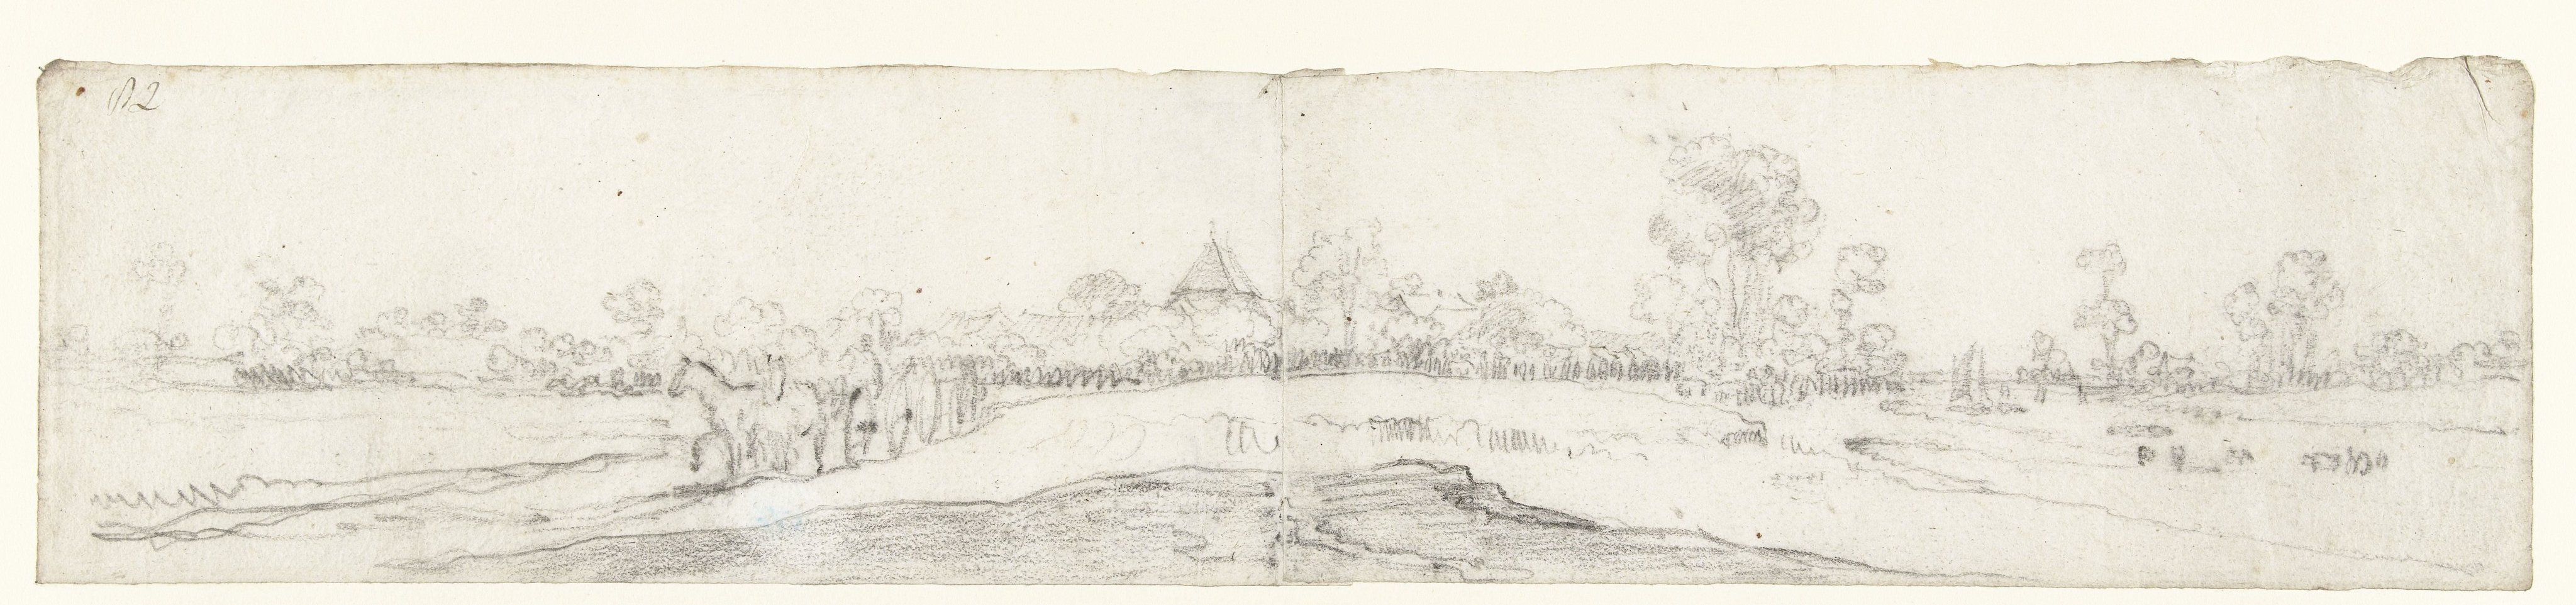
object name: drawing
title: Landschap met een paard en wagen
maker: gerard ter borch (ii)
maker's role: draughtsman, painter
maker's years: 1617-1681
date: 1645-1681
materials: chalk, paper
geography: zwolle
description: Waarschijnlijk een landschap langs de IJssel tussen Zwolle en Deventer. Getekend op dubbele bladen van een schetsboek.